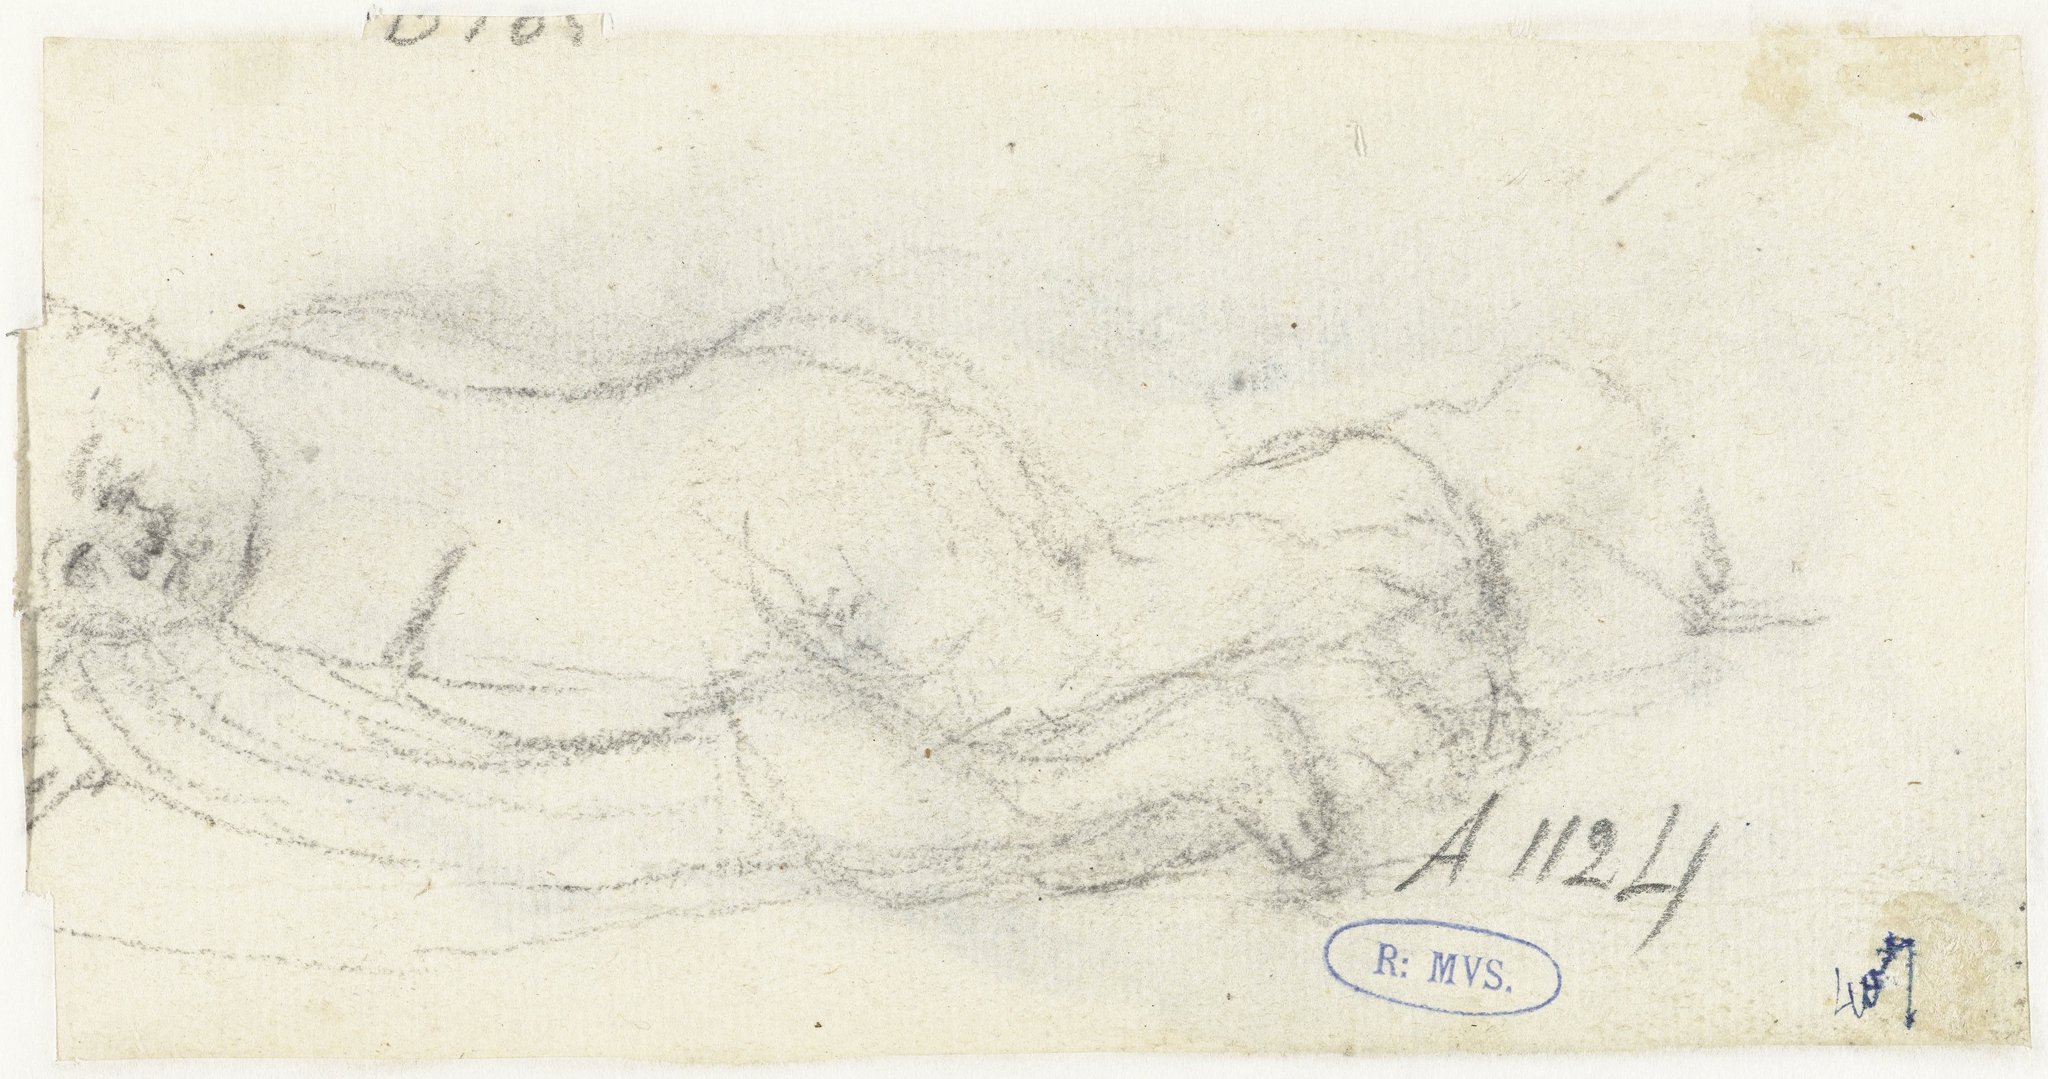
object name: drawing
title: Oefenschets van slapend kind, liggend op een kussen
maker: moses ter borch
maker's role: draughtsman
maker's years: 1645-1667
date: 1657-1658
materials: chalk, paper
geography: zwolle